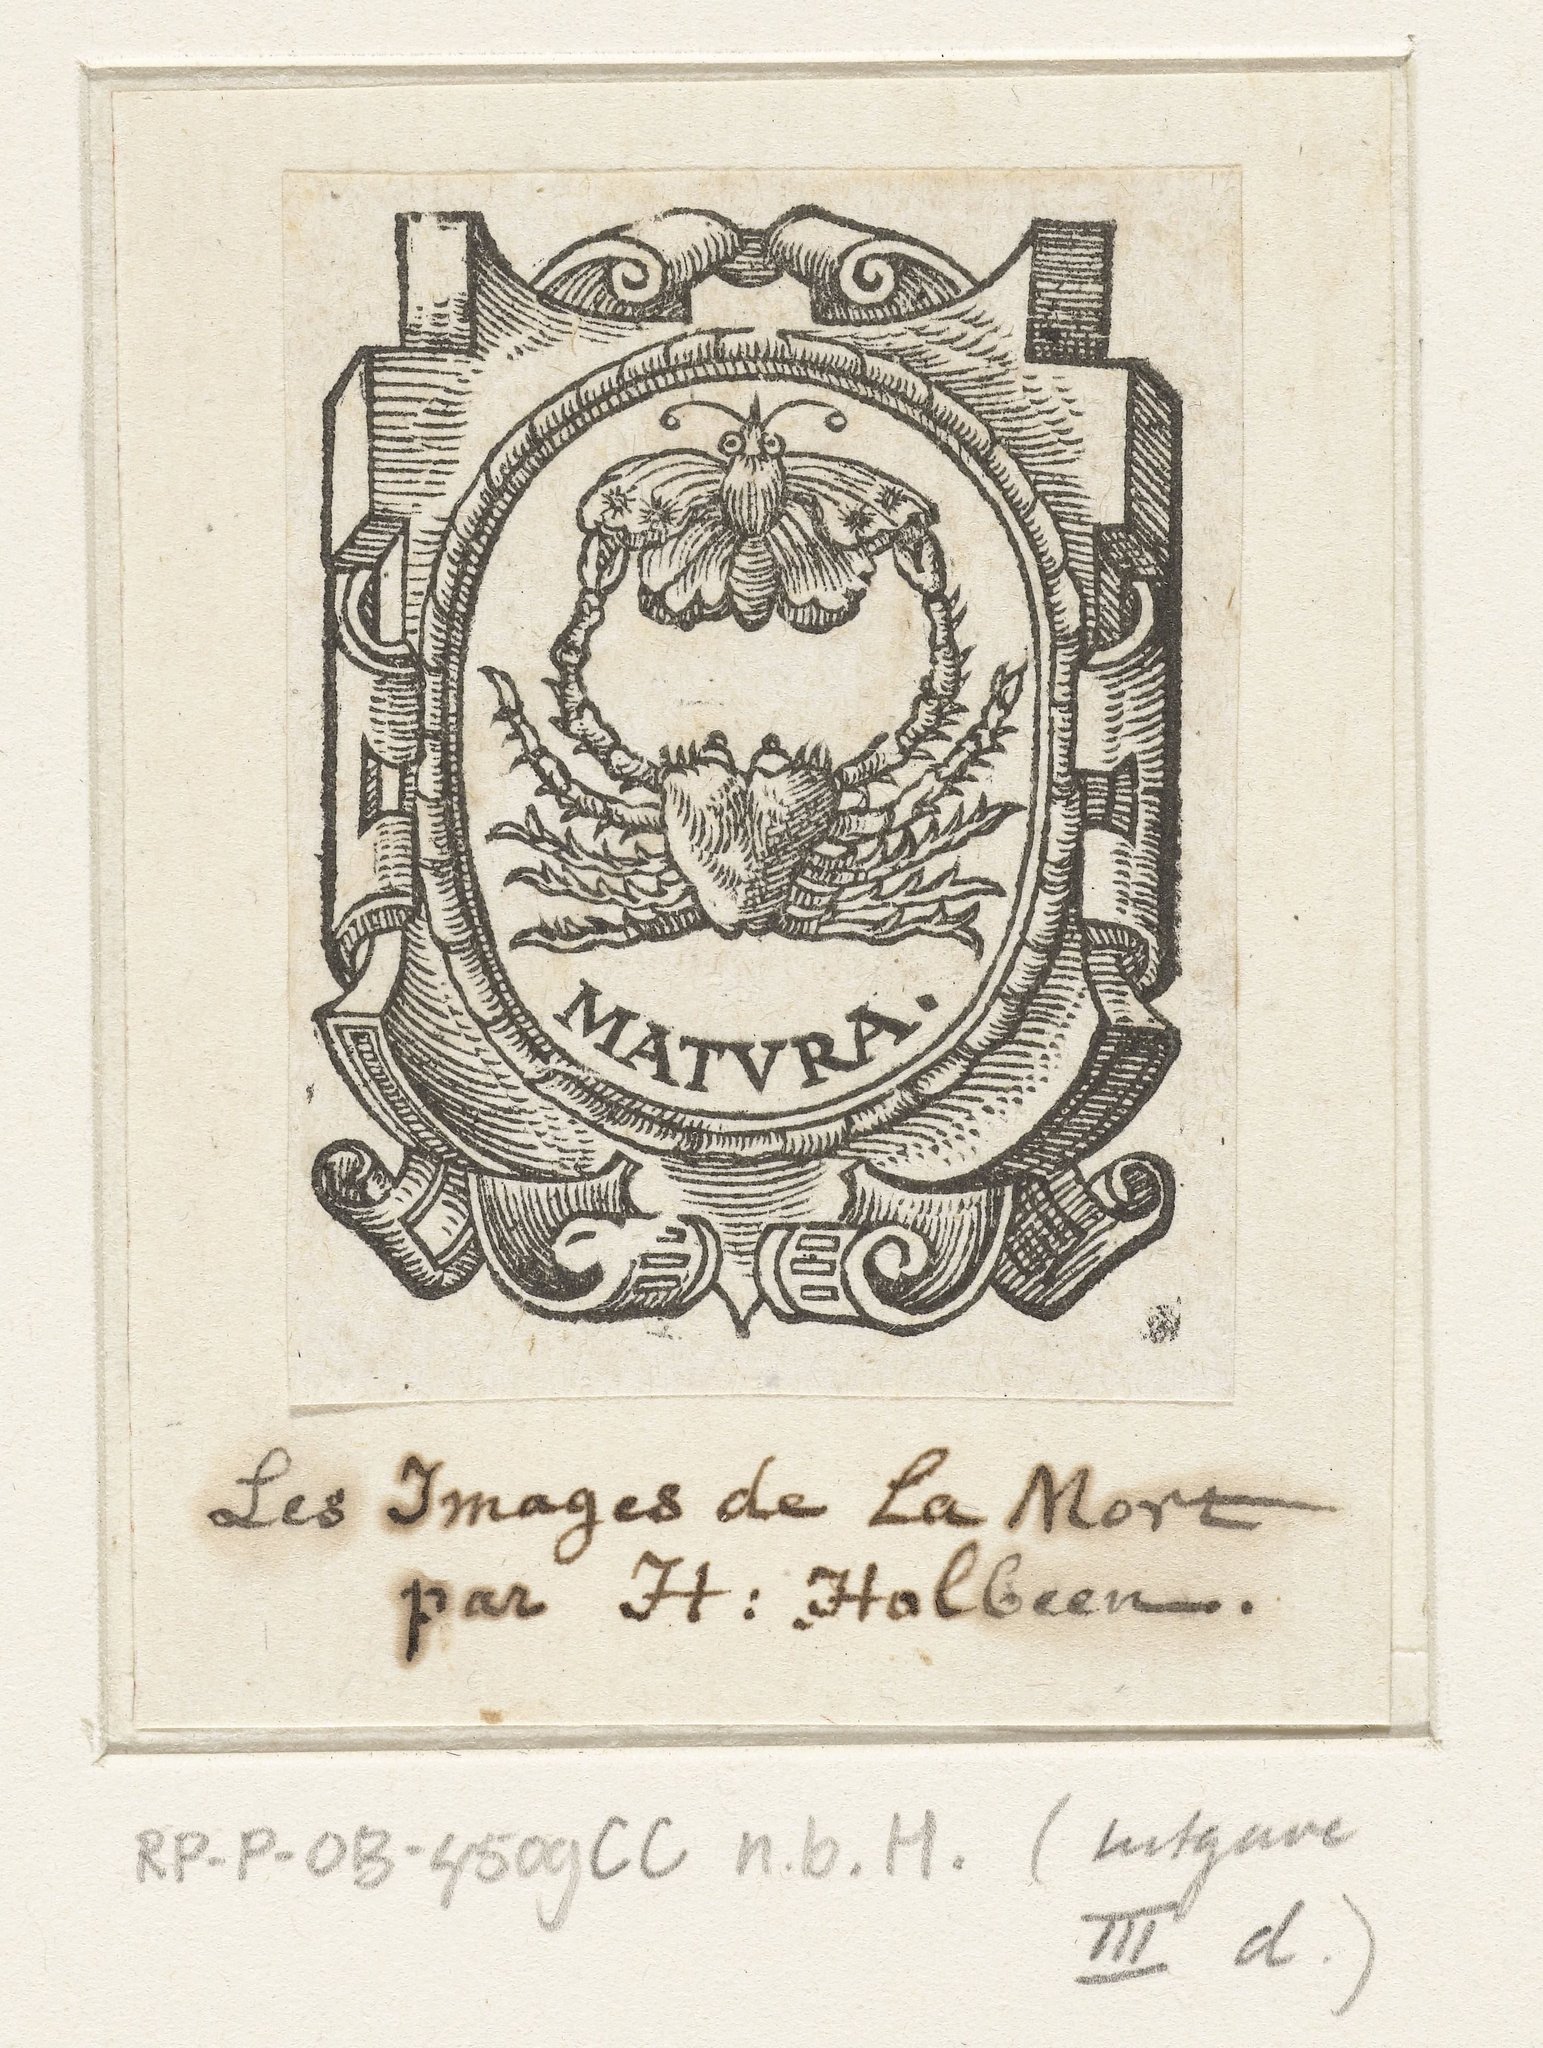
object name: book illustration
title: Dodendans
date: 1538-1562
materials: paper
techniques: woodcut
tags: crustaceans, dance of death; death together with one or more human beings, insects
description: Deze prent wordt niet genoemd in Hollstein. De afgesneden kleine prent is geplakt op een ander blad en onder de prent staat met pen in bruin de Franse titel van een uitgave: Les images de La Mort par H: Holbeen. Dit opschrift verwijst naar de uitgave: Les images de la Mort, Auxquelles sont adioustées dix-sept figures. Davantage, La Medicine de l'Ame ... Lyon 1562, S. Barbier (voor J. Frellon). Het is onduidelijk of het houtblok voor deze voorstelling voor een eerdere uitgave werd gesneden en of het ontwerp van Hans Holbein is. Het krab-vlinder motief was het drukkersmerk van Jean II en François Frellon, boekverkopers in Lyon en uitgevers van Holbein.